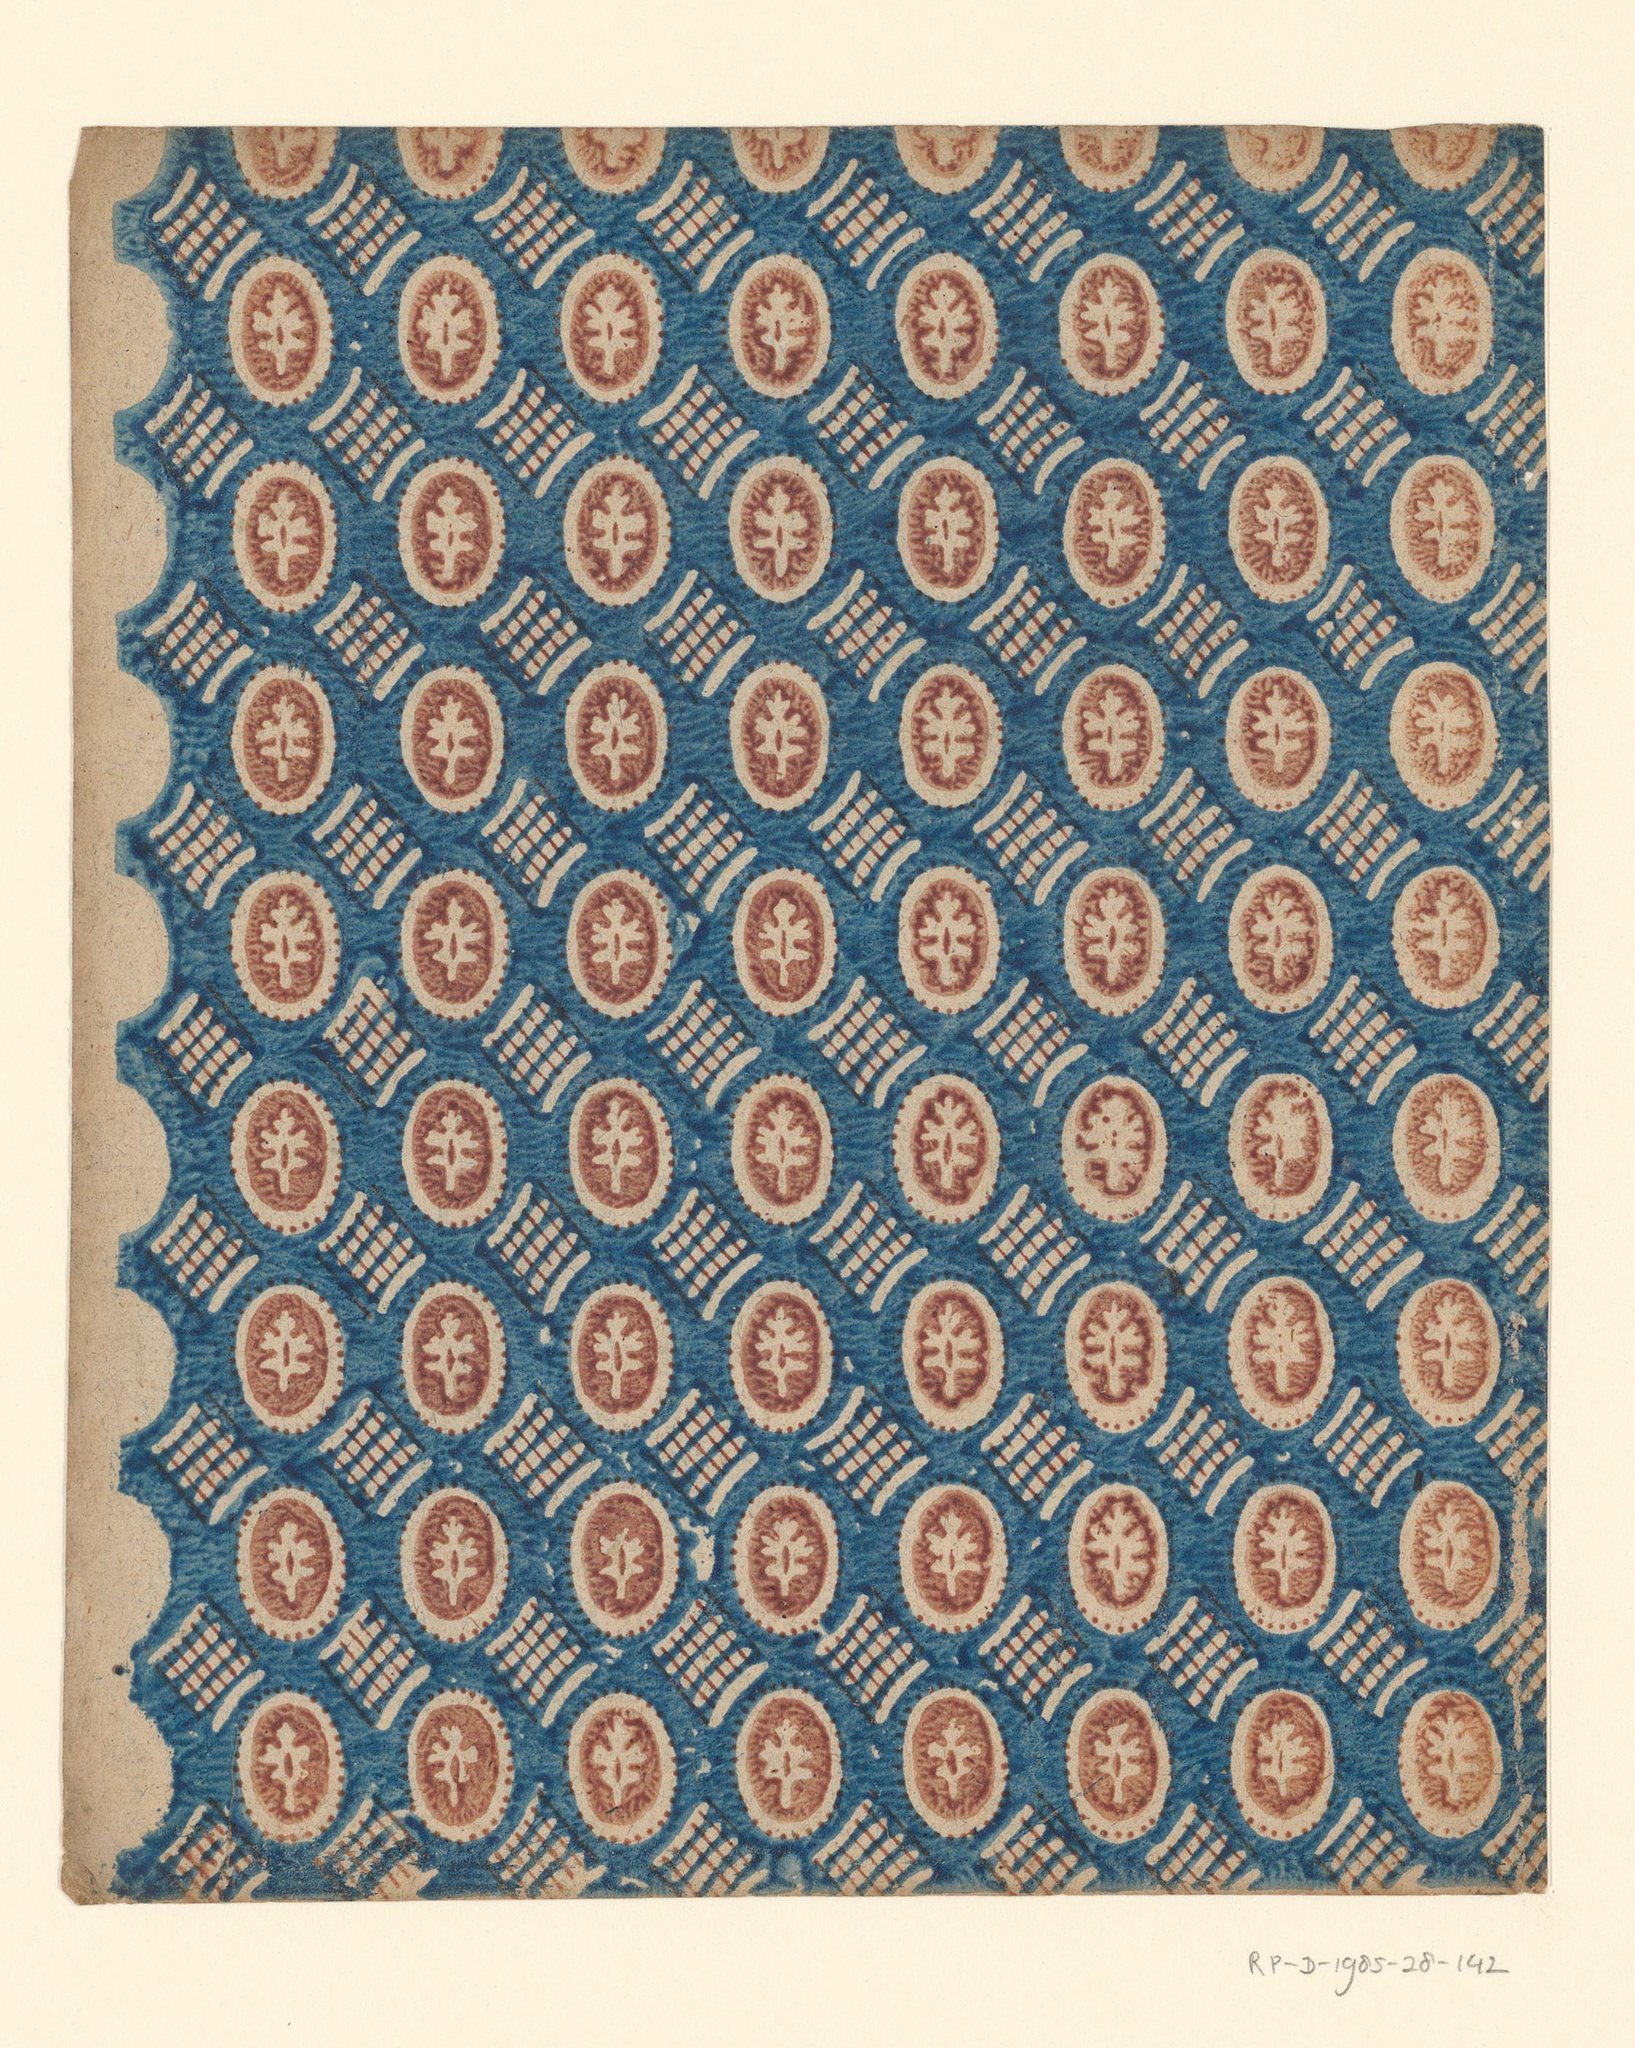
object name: wrapper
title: Blad met alternerend strooipatroon van uitgespaarde ovaal met takje en ruitmotief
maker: Anonymous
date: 1750-1900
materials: paper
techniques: printing block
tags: ornament derived from plant forms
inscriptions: collector's mark: Lugt 2228, collector's mark: Lugt 2760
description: Blad met alternerend strooipatroon van uitgespaarde ovaal met takje en ruitmotief. Helft van een omslag.